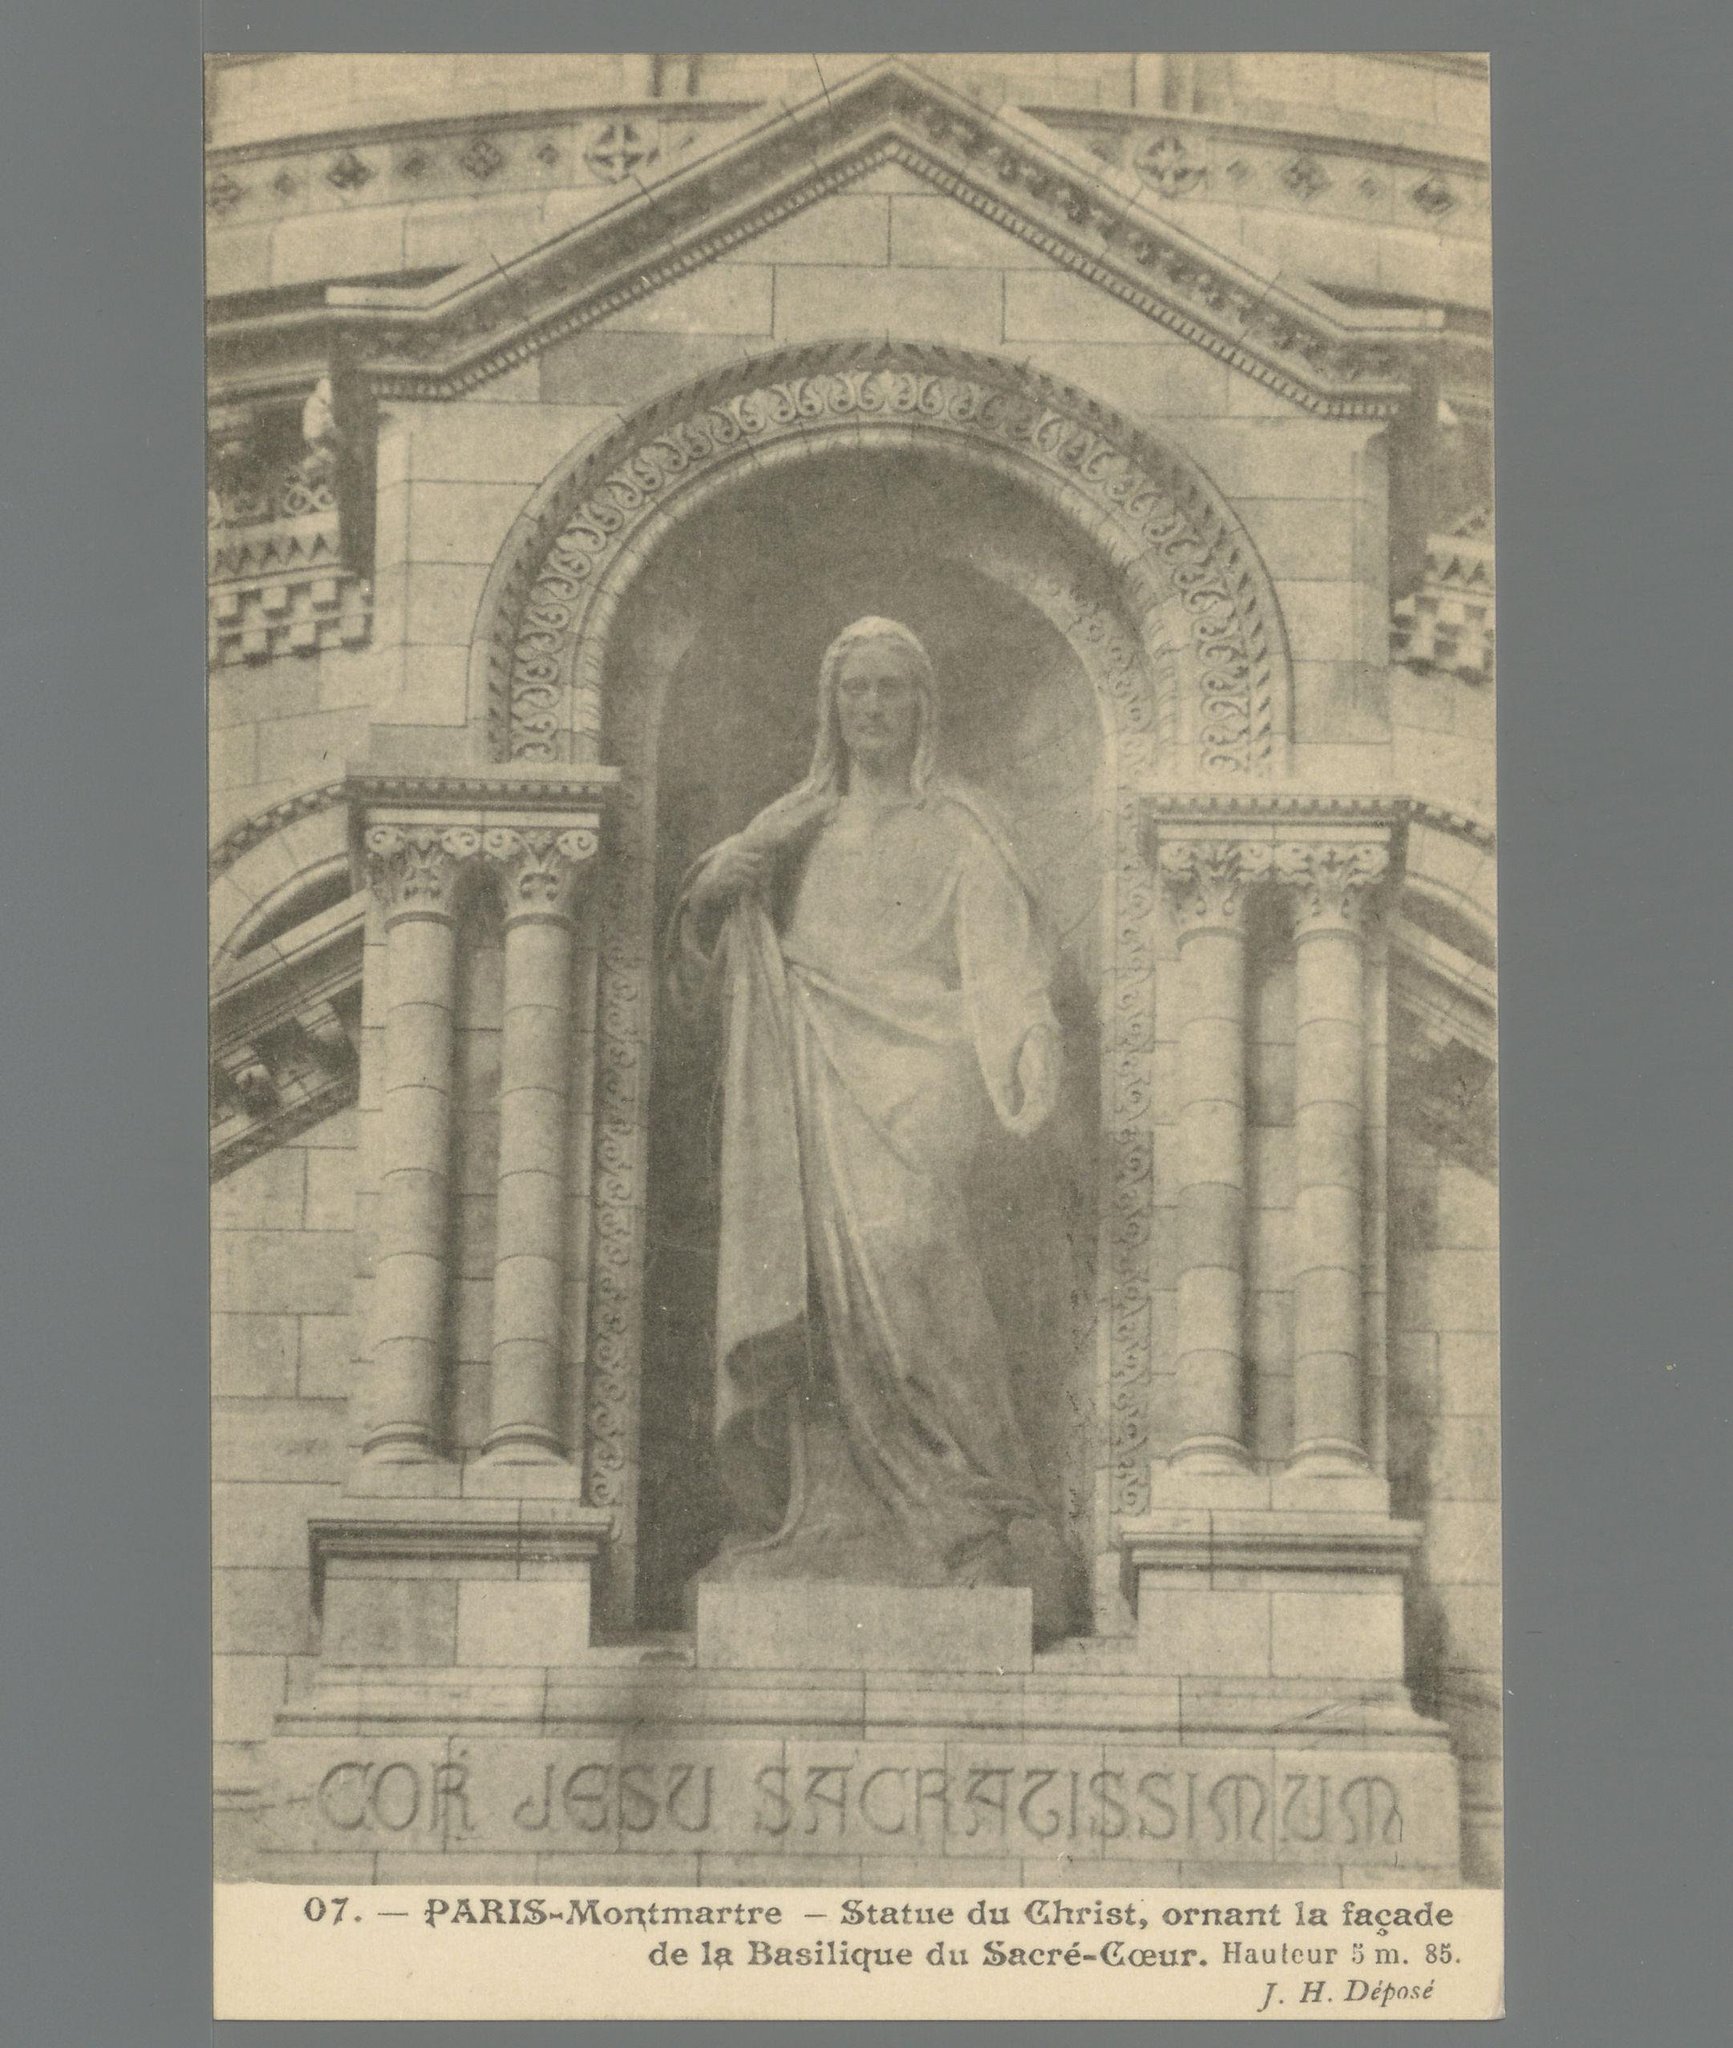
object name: photomechanical print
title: Paris-Montmartre. Statue du Christ, ornant la façade de la Basilique du Sacré-Coeur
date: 1903-1920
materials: cardboard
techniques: photograph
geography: paris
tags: church (exterior), sculpture